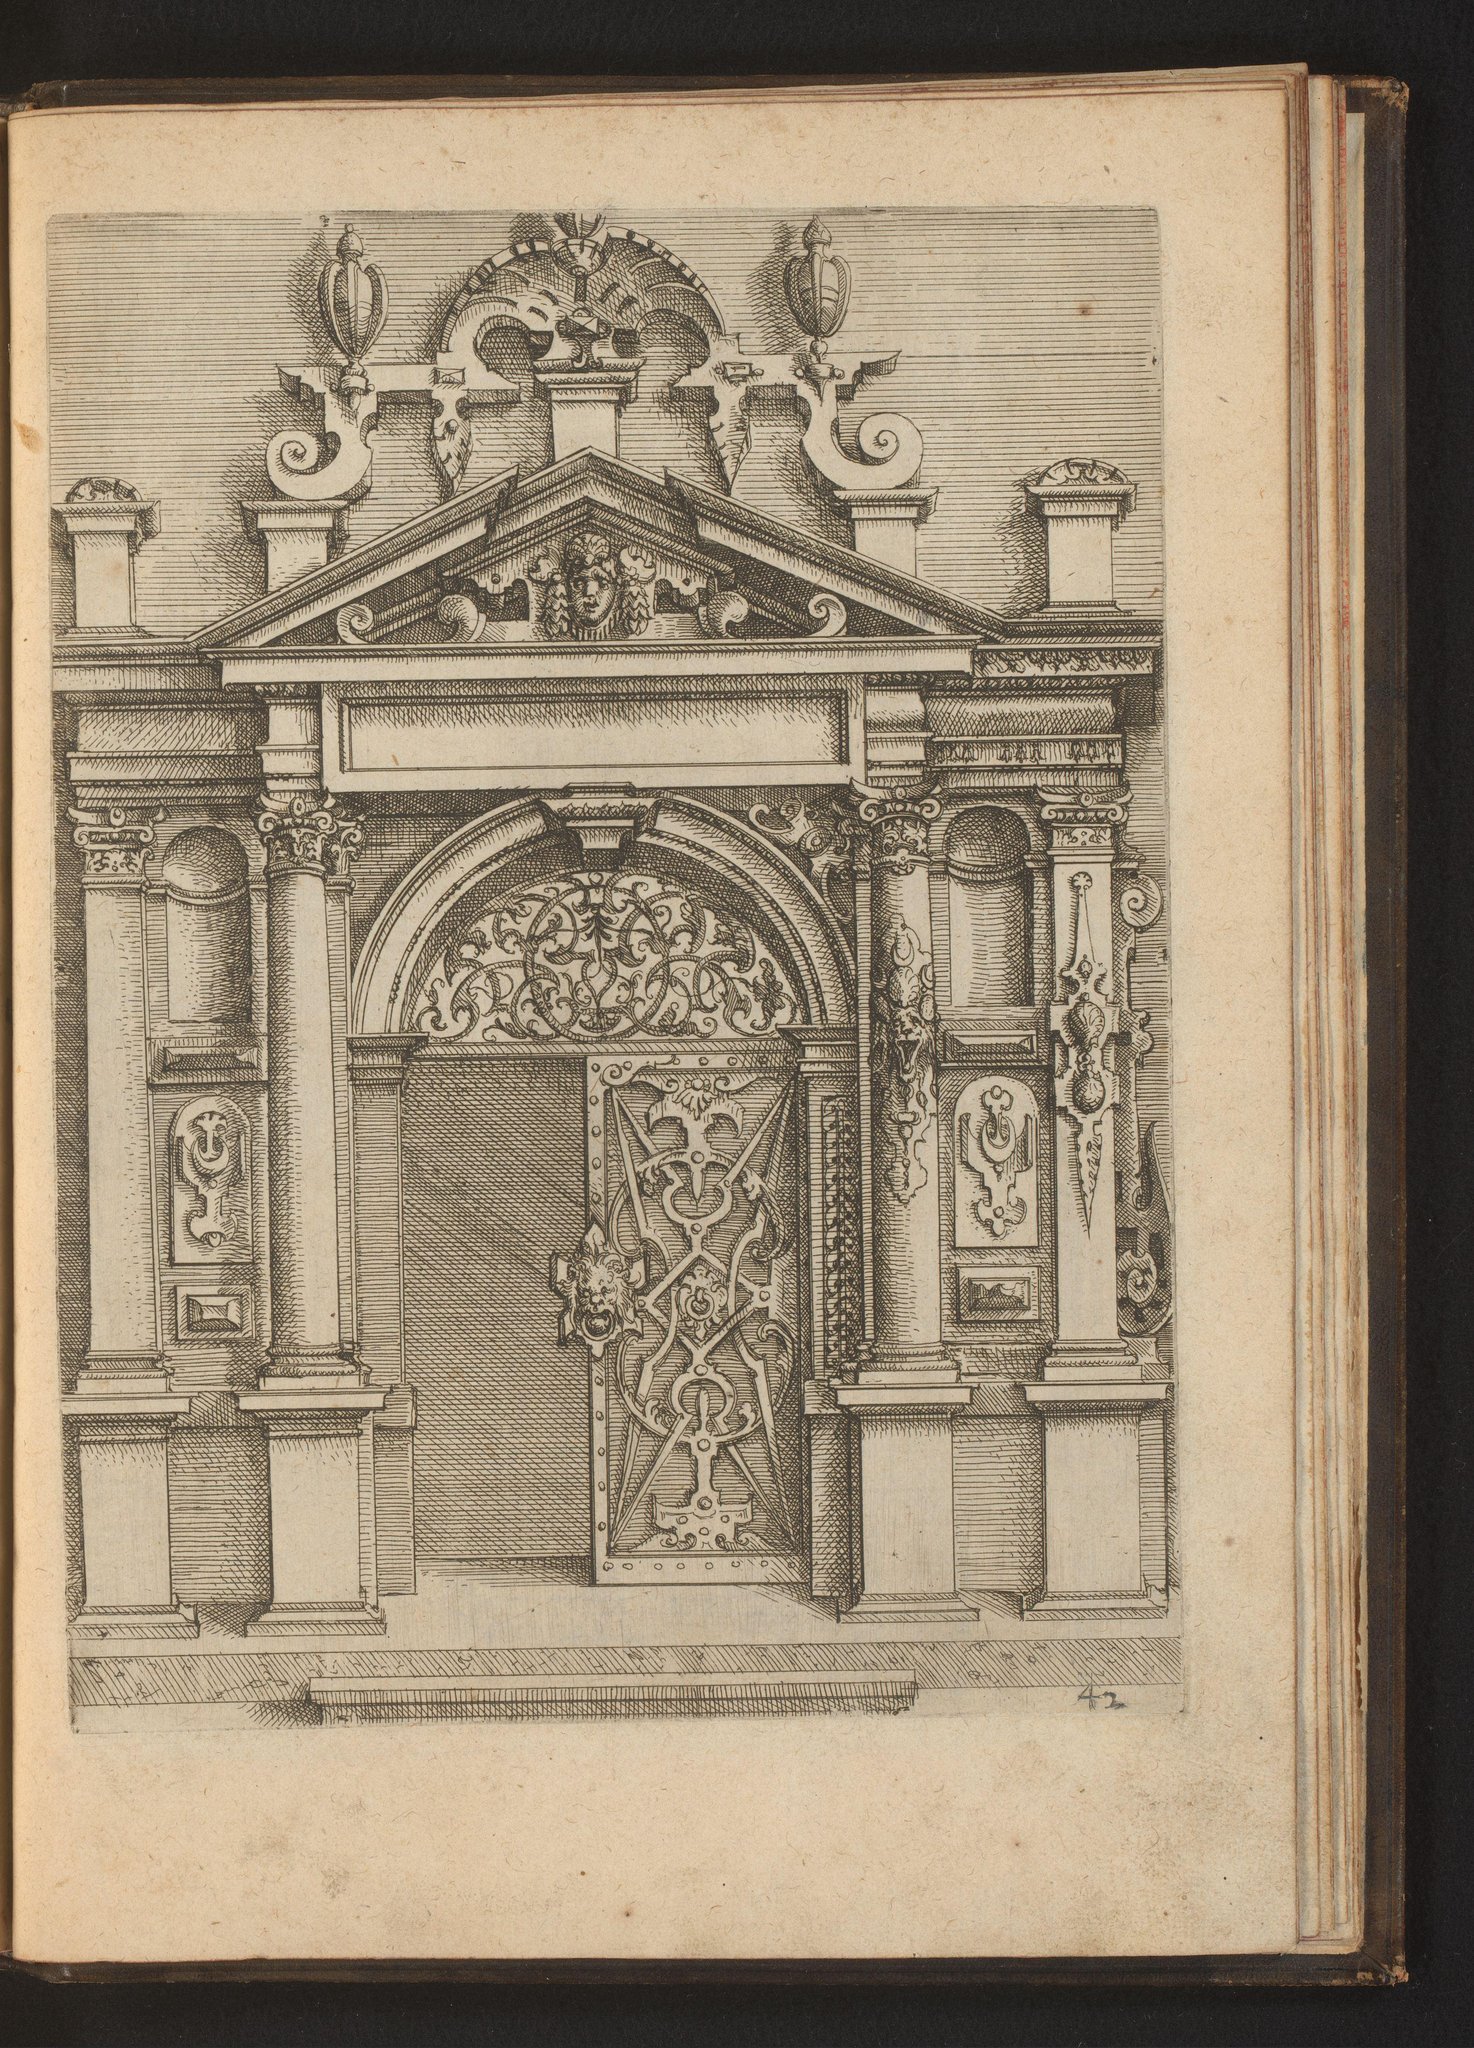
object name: ornament print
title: Architectura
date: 1593-1595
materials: paper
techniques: etching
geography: straatsburg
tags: parts of church exterior and annexes: portal, mask, mascaron ~ ornament, ornament derived from architectural details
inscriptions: collector's mark: Lugt 2760, collector's mark: Lugt 2228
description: Prent gebruikt in: Dietterlin, Wendel (I). Wendel Dietterlin, Architectura de Polstium seu Portalium ornatu uario Liber II. Straatsburg: Bernhard Jobin, 1594.